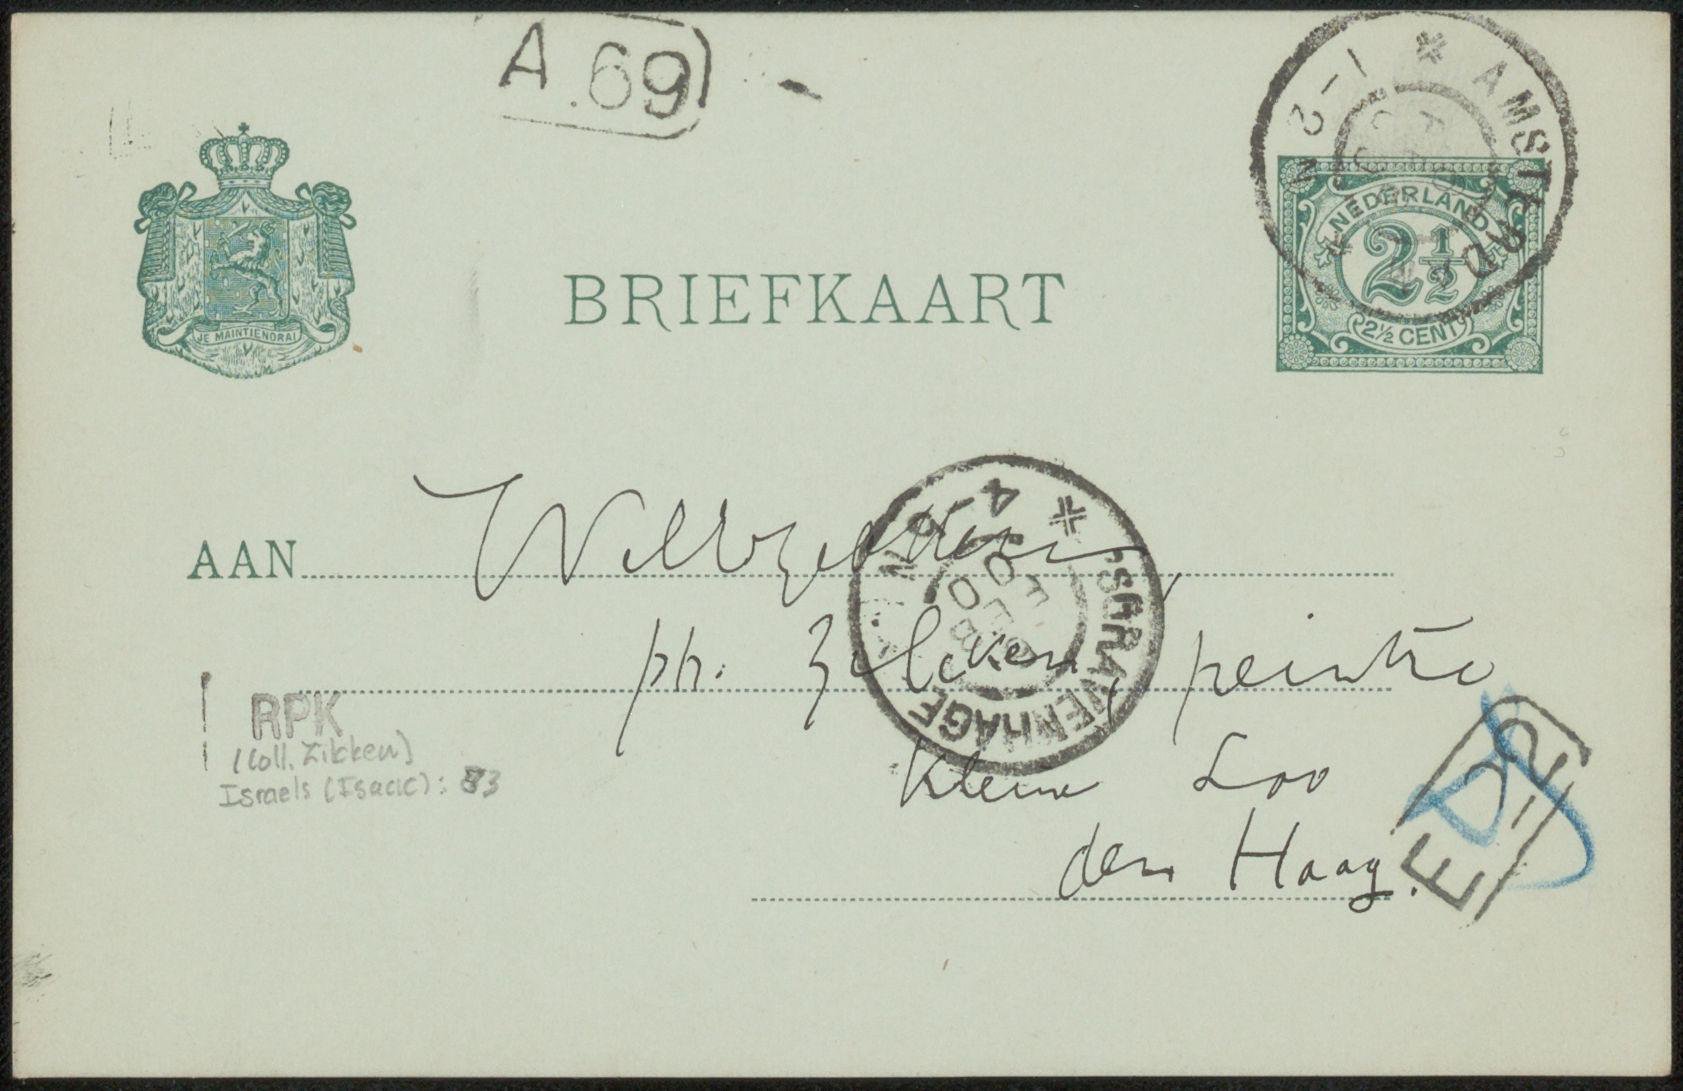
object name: postcard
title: Briefkaart aan Philip Zilcken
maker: isaac israels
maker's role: draughtsman, painter, print maker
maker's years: 1865-1934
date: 1900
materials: cardboard, ink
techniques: writing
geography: amsterdam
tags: frans erens, philip zilcken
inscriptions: collector's mark: ‘RPK’